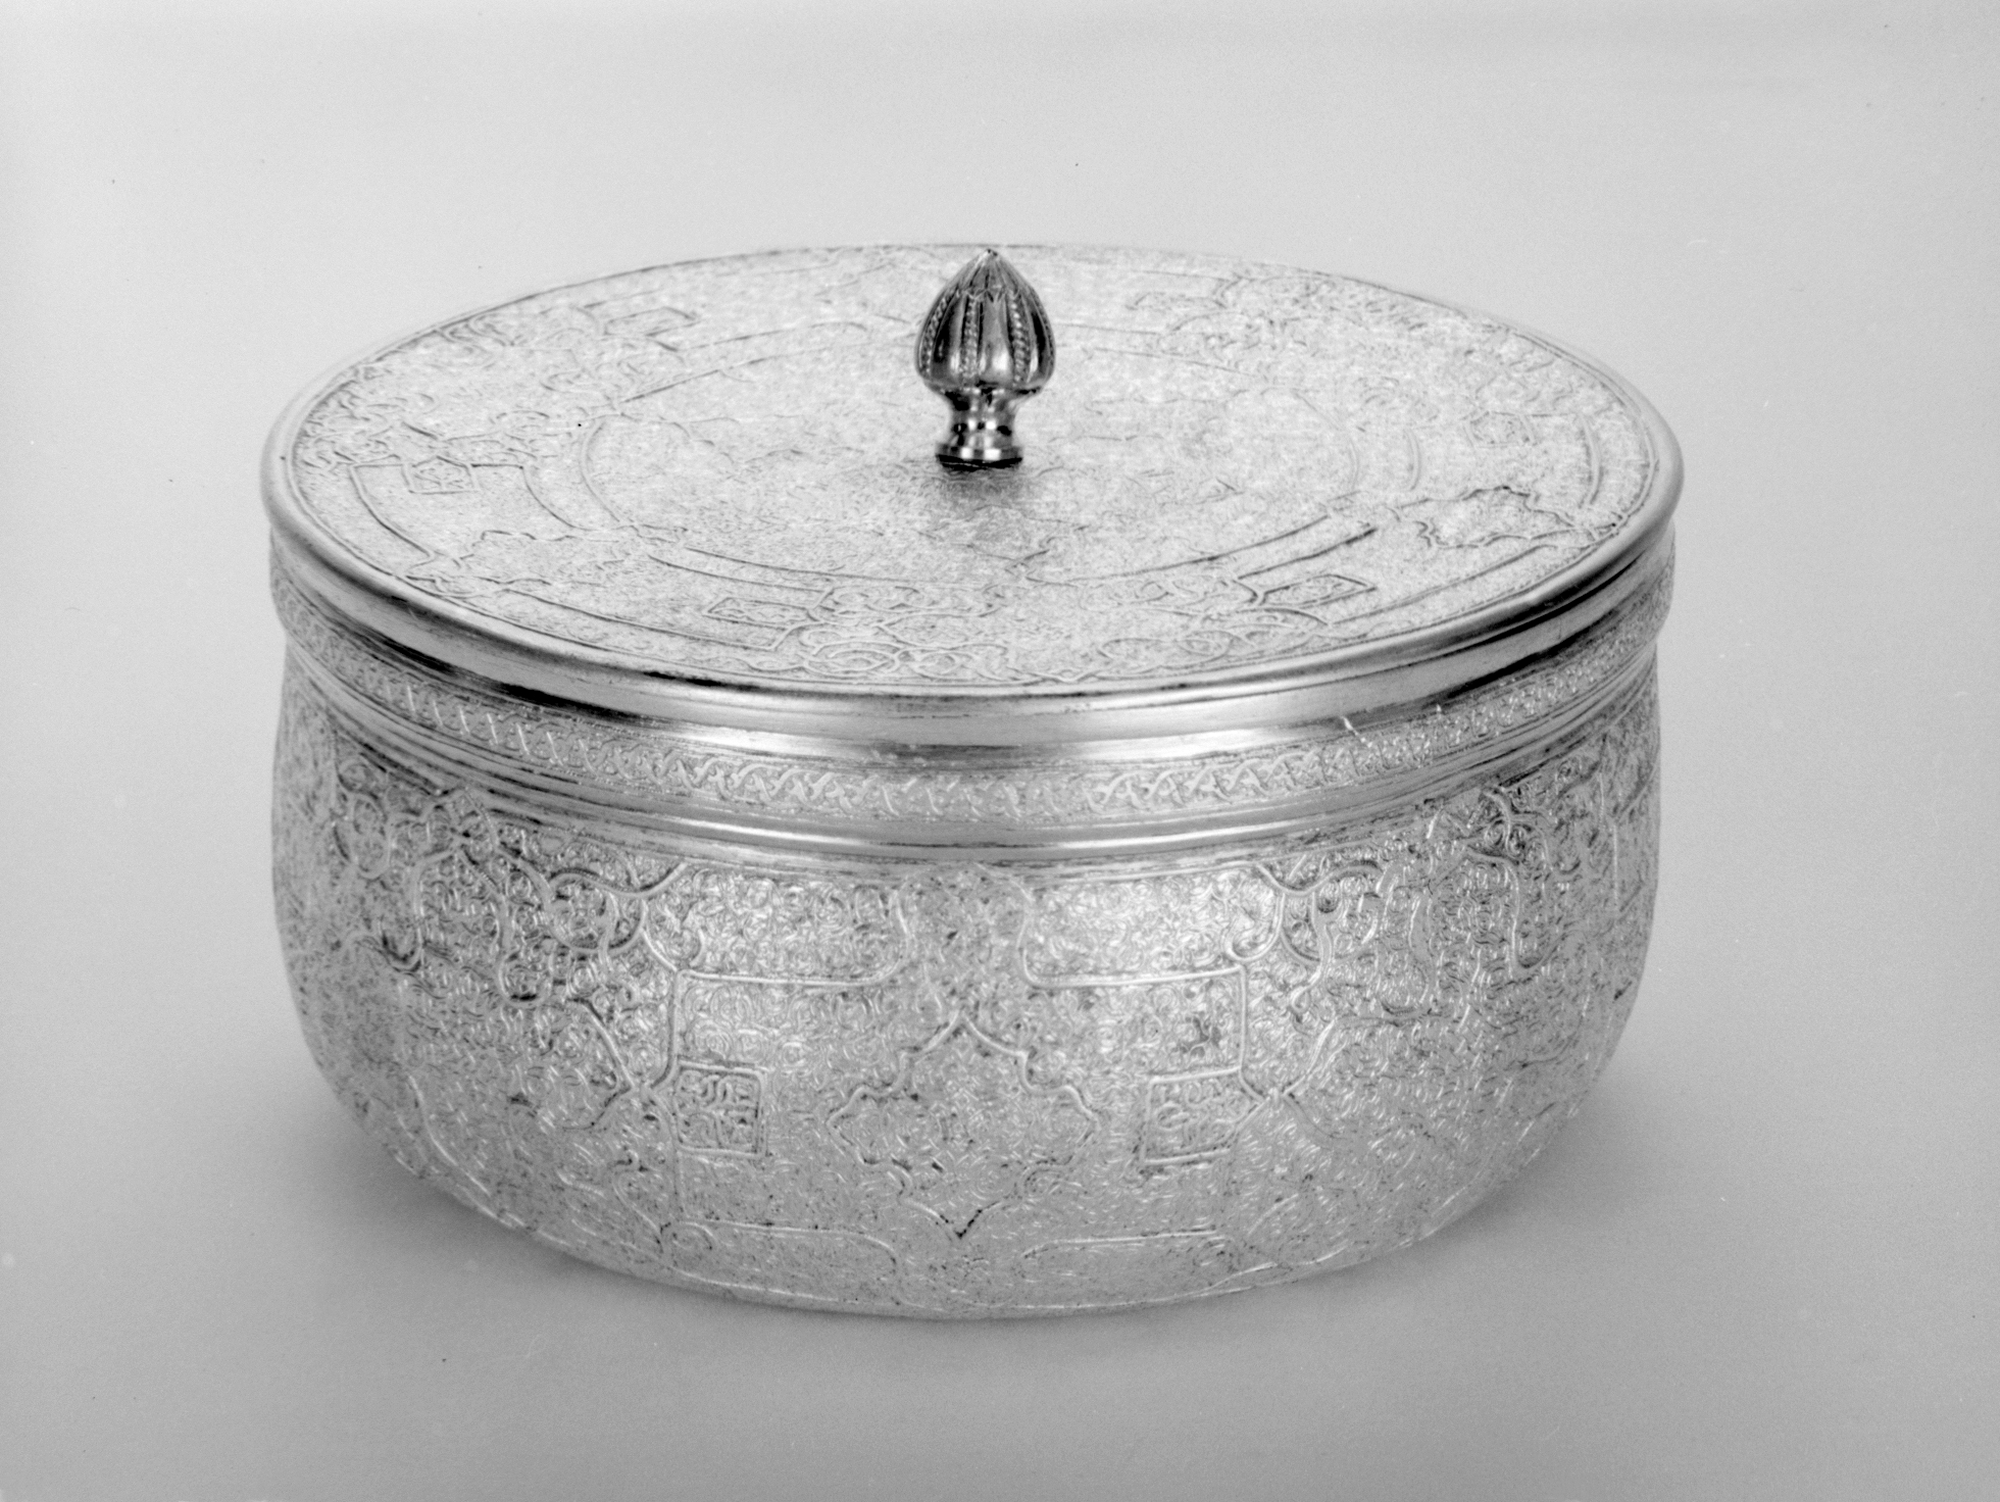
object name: bowl with cover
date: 1801-1900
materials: brass